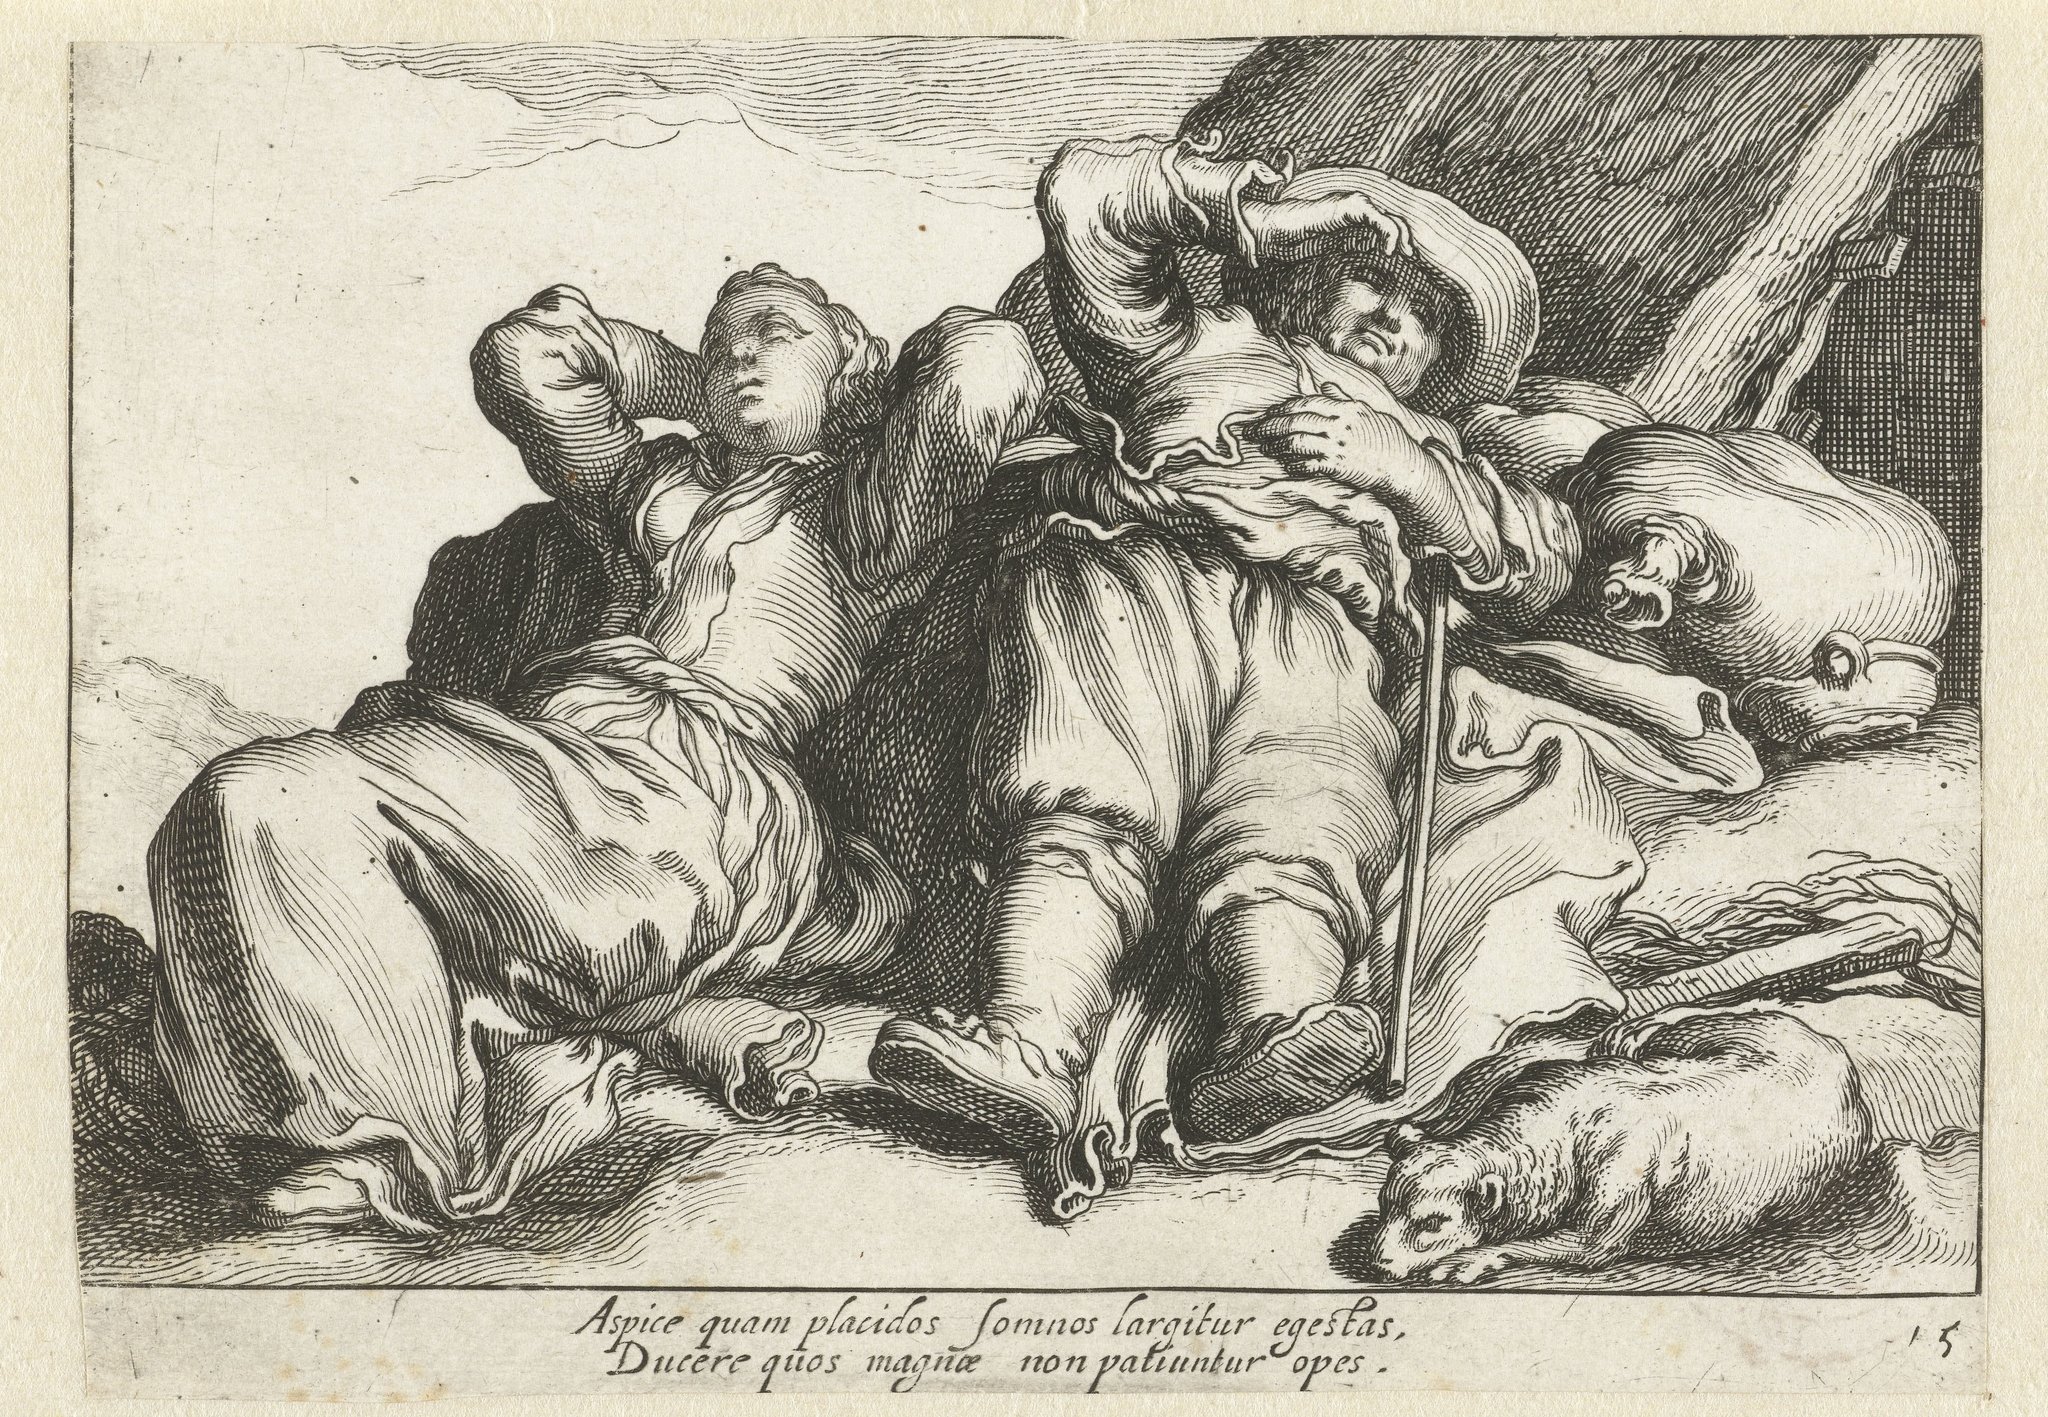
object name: print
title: Pastorale scènes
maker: cornelis bloemaert (ii)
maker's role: draughtsman, print maker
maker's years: 1603-1692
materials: paper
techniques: engraving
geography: utrecht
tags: sleeping on the ground, container of leather: leather bag, pastorals, arcadian scenes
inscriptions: collector's mark: Lugt 240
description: Een man en vrouw liggen uit te rusten tegen een boom. Naast hen een drinkzak en een hond. Met tweeregelig Latijns onderschrift.